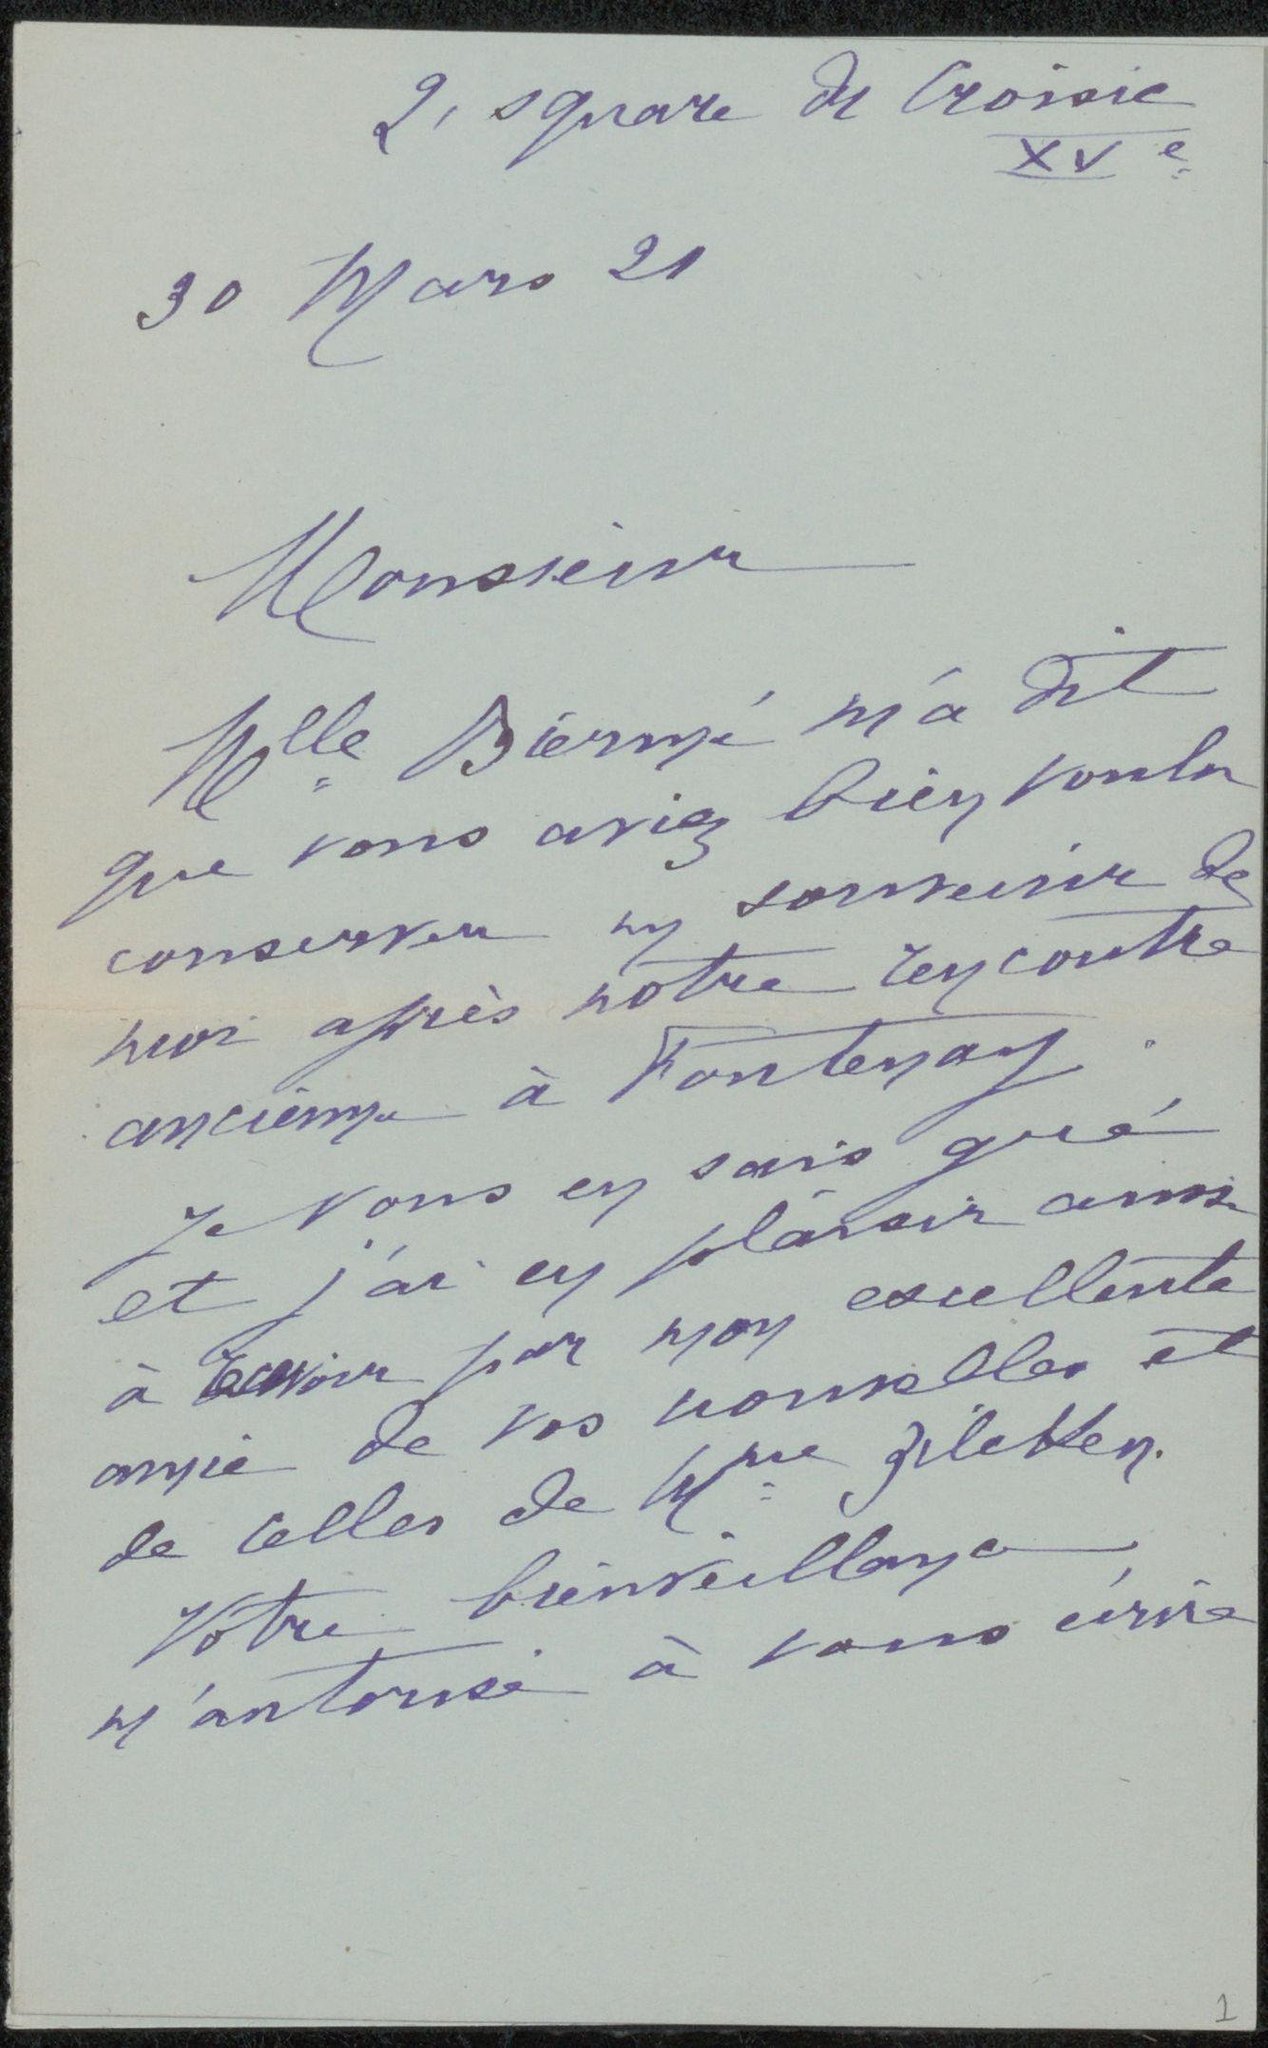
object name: letter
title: Brief aan Philip Zilcken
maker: lya berger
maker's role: schrijver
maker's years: 1877-1941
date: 1921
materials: ink, paper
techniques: pen, writing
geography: paris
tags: the hague, painter, draughtsman, philip zilcken, paris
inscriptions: collector's mark: ‘RPK’